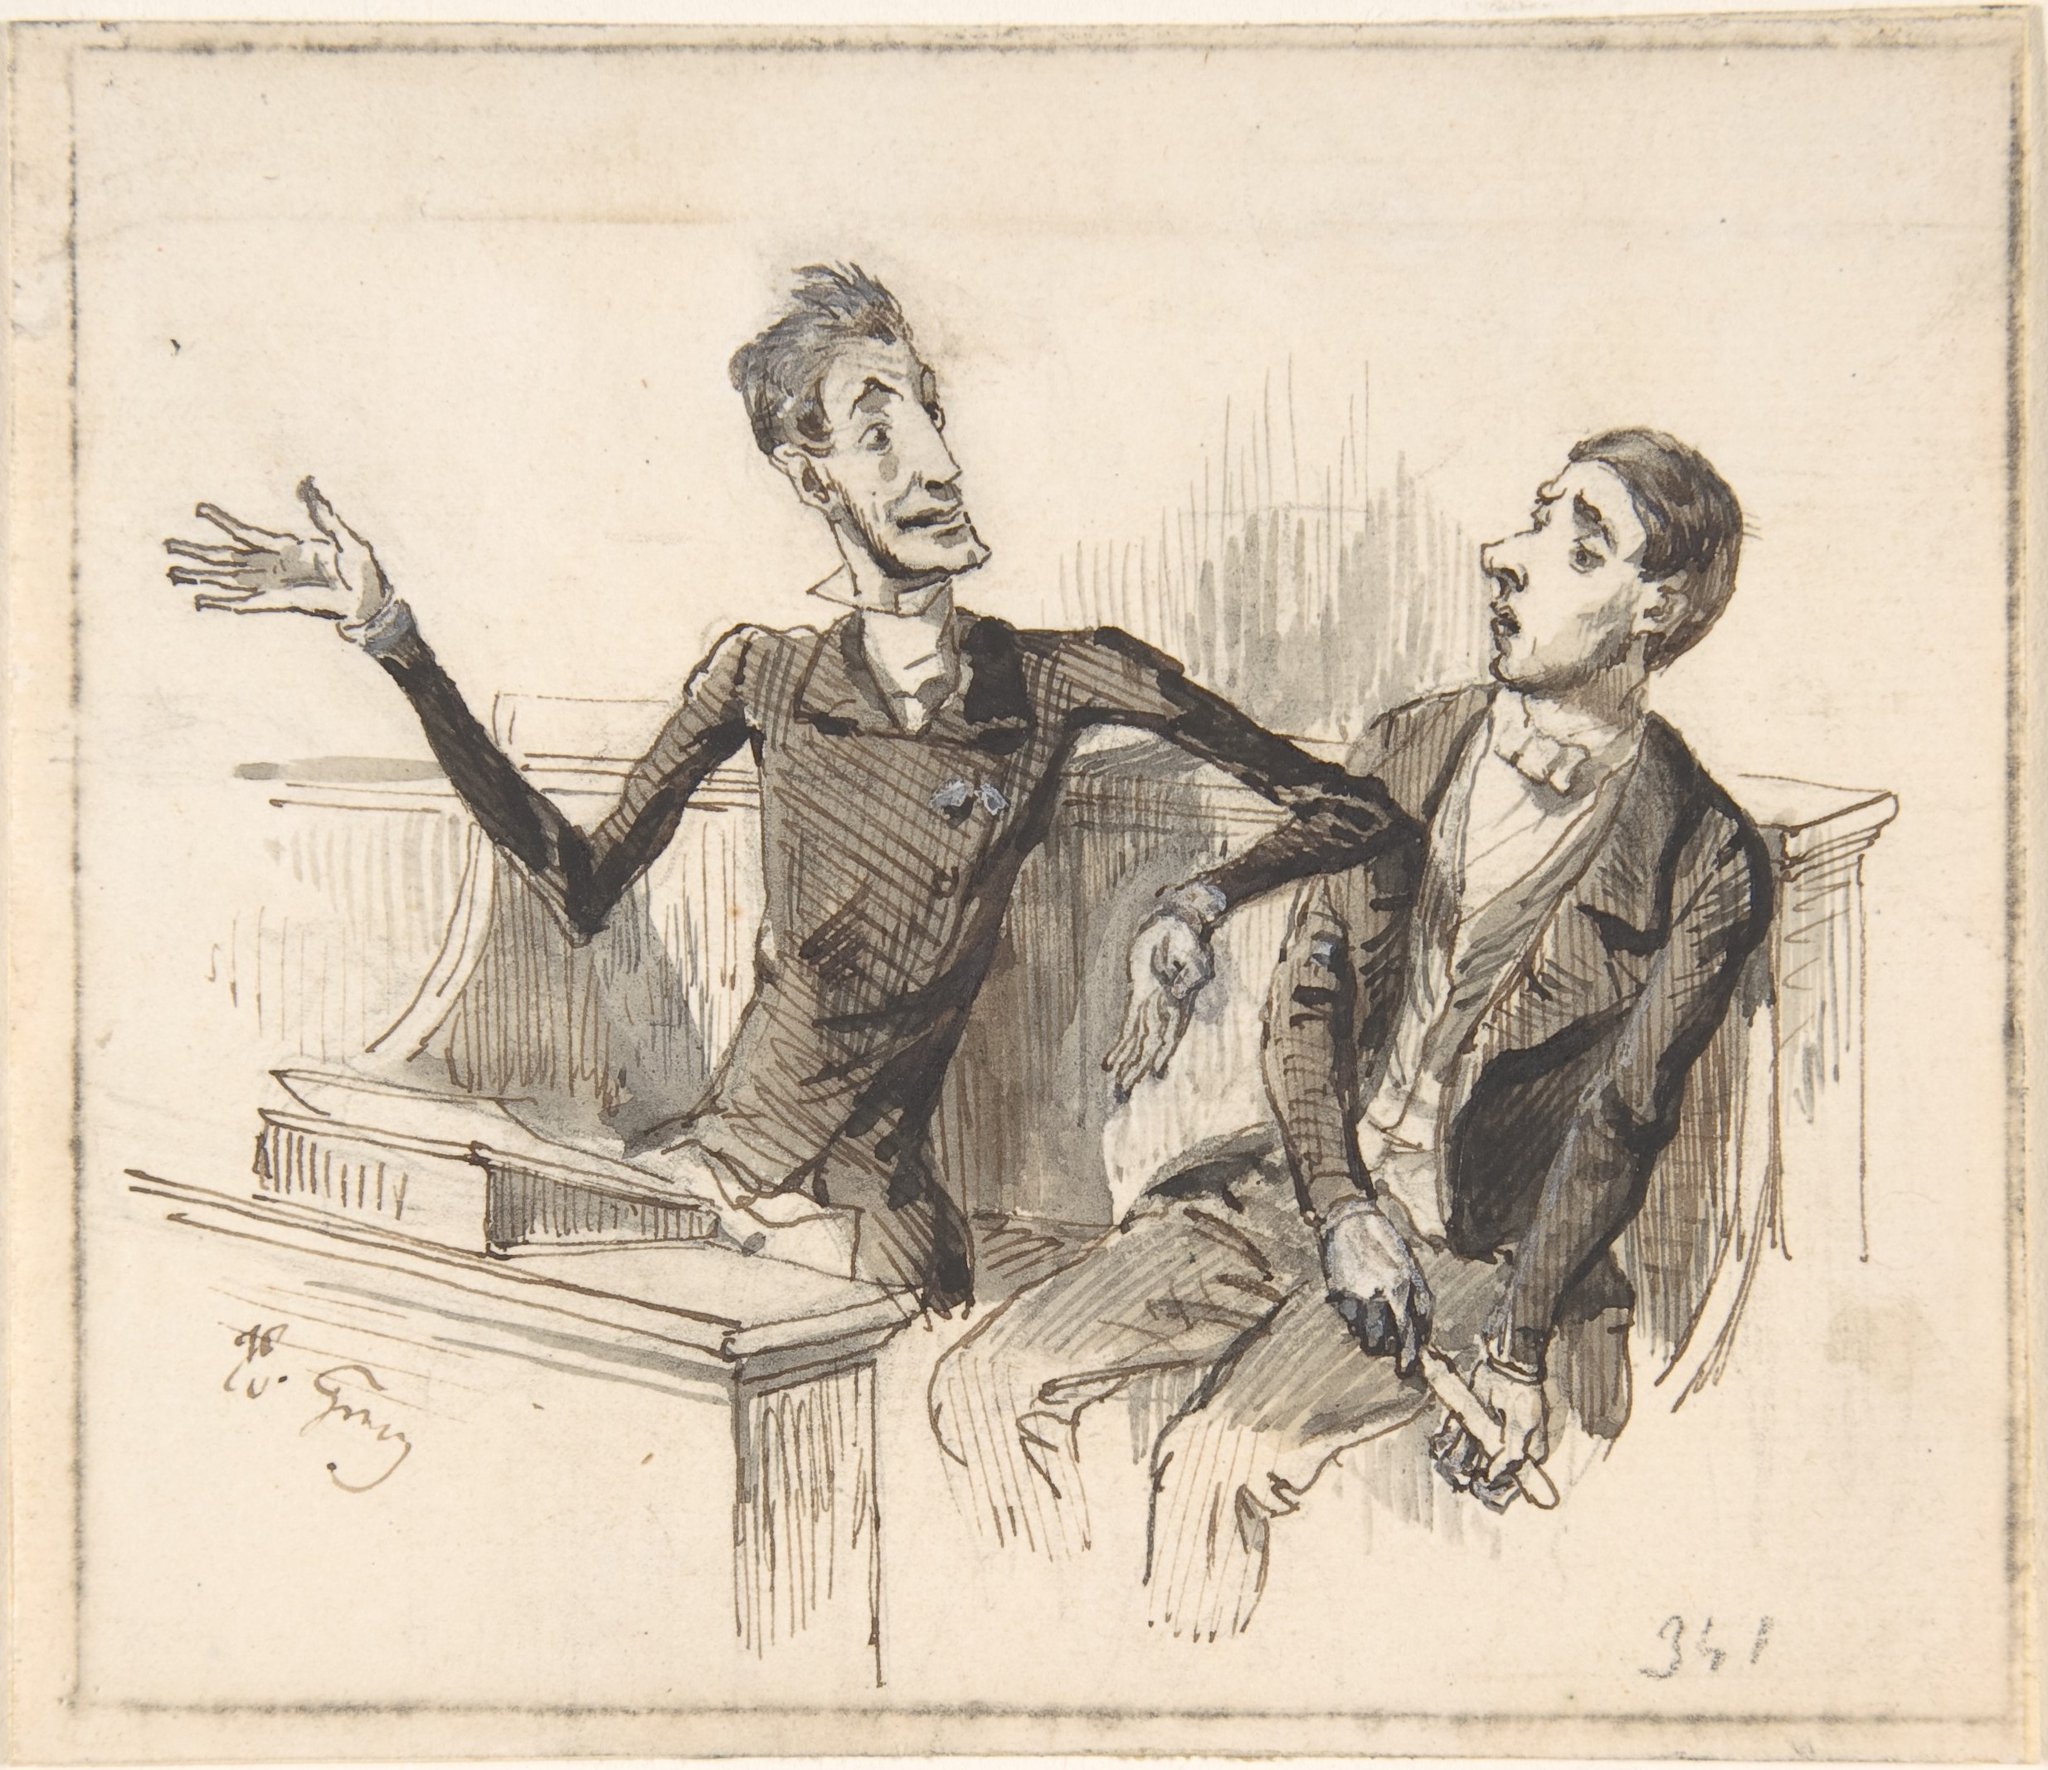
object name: drawing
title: Illustration in Jérôme Paturot, by Louis Reybaud, Paris, 1846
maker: j. j. grandville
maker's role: artist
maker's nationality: french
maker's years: 1803-1847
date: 1846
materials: graphite, ink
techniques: brush, pen, wash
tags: men